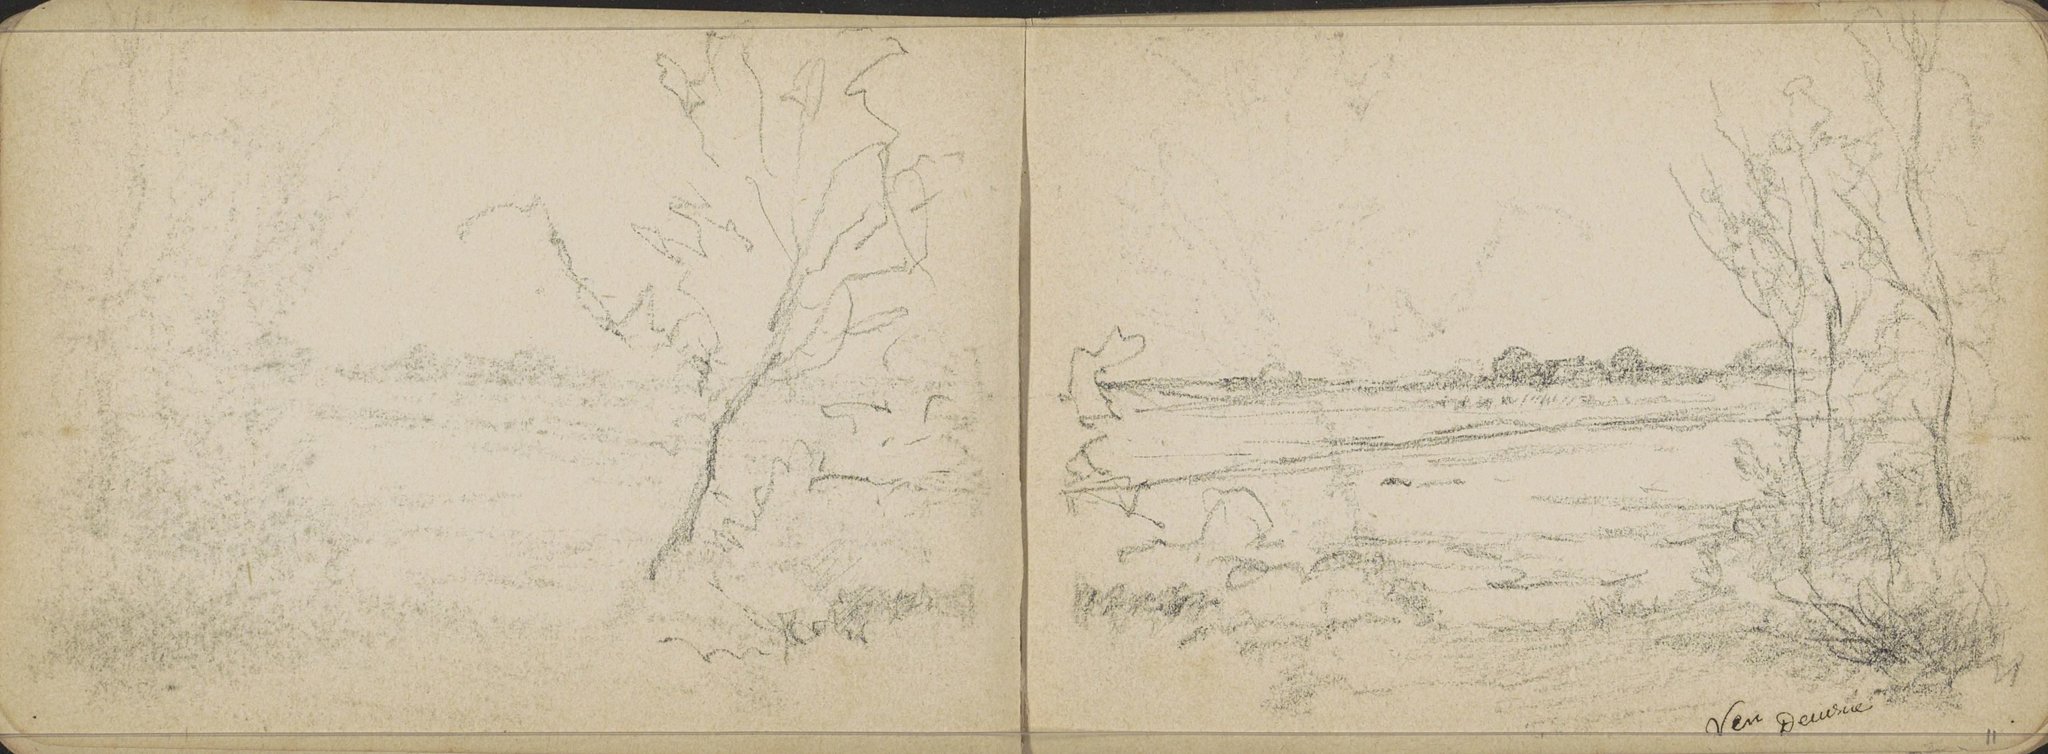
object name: sketchbook leaf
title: Landschap bij Deurne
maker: willem cornelis rip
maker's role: draughtsman, painter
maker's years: 1856-1922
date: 1896-1897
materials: chalk, paper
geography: deurne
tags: village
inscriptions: annotation: ‘van Deurne’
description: Blad 10 verso en 11 recto uit een schetsboek met 44 bladen.